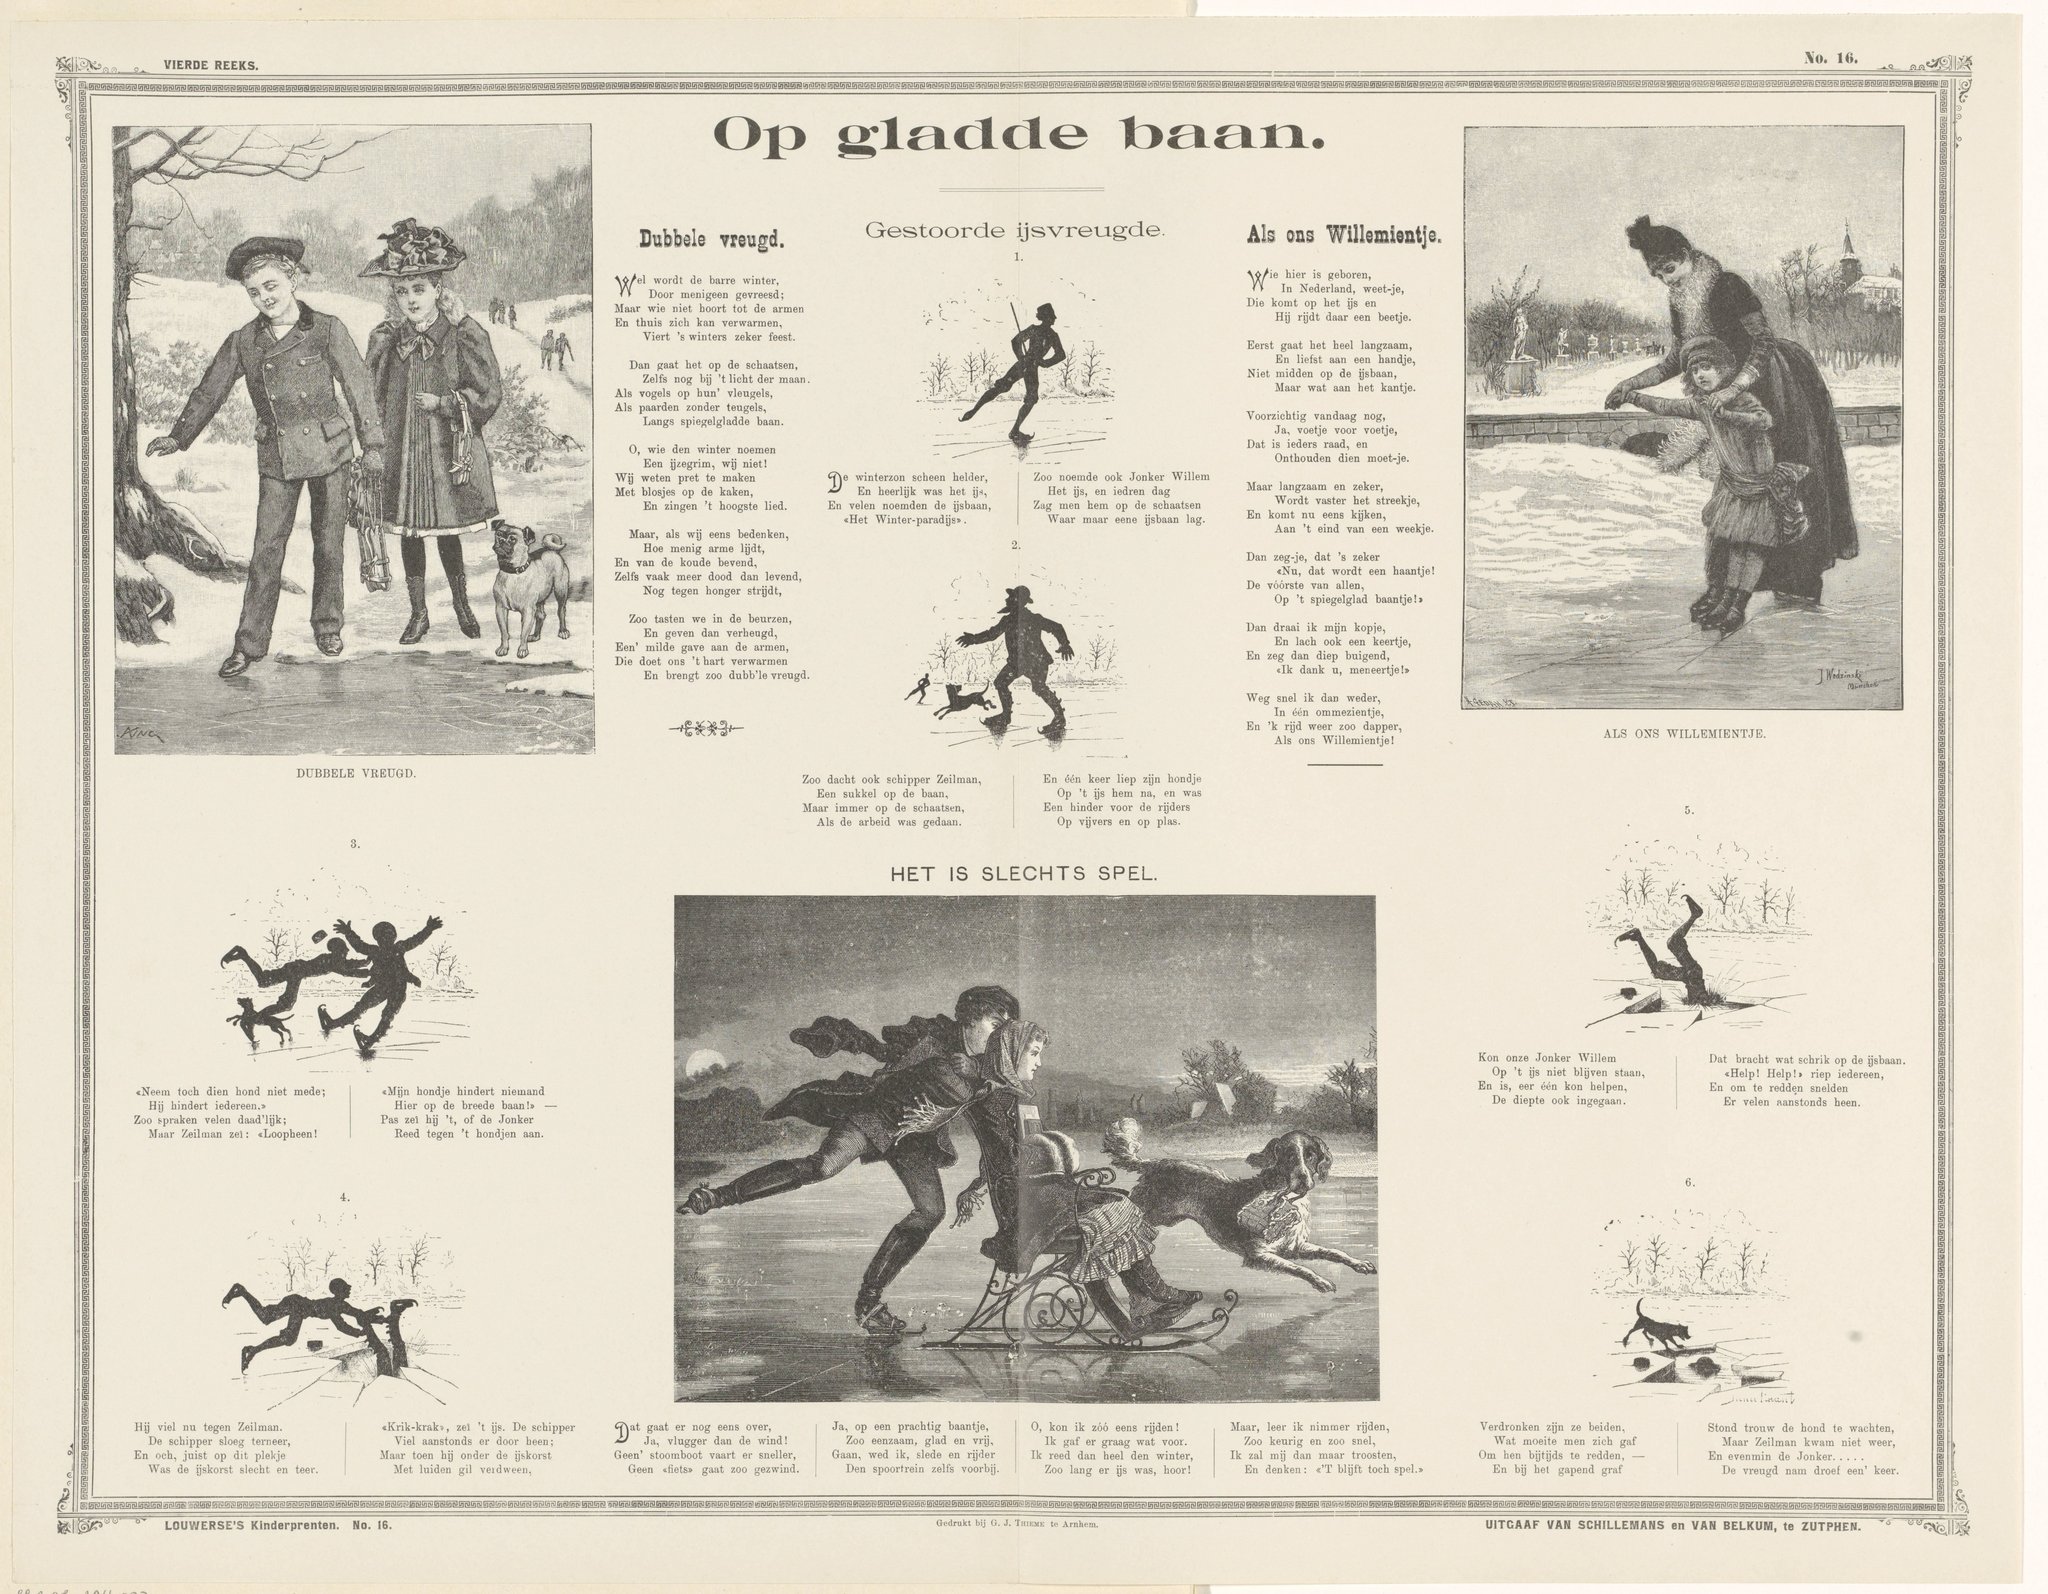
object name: print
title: Louwerse's kinderprenten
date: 1905-1924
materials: paper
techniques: letterpress printing, printing block, engraving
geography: arnhem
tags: skates (winter sports), accident on snow or ice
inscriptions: collector's mark: Lugt 2760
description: Blad met 9 voorstellingen van kinderen op het ijs. Tussen de afbeeldingen versjes in boekdruk. Genummerd rechtsboven en linksonder: No. 16.